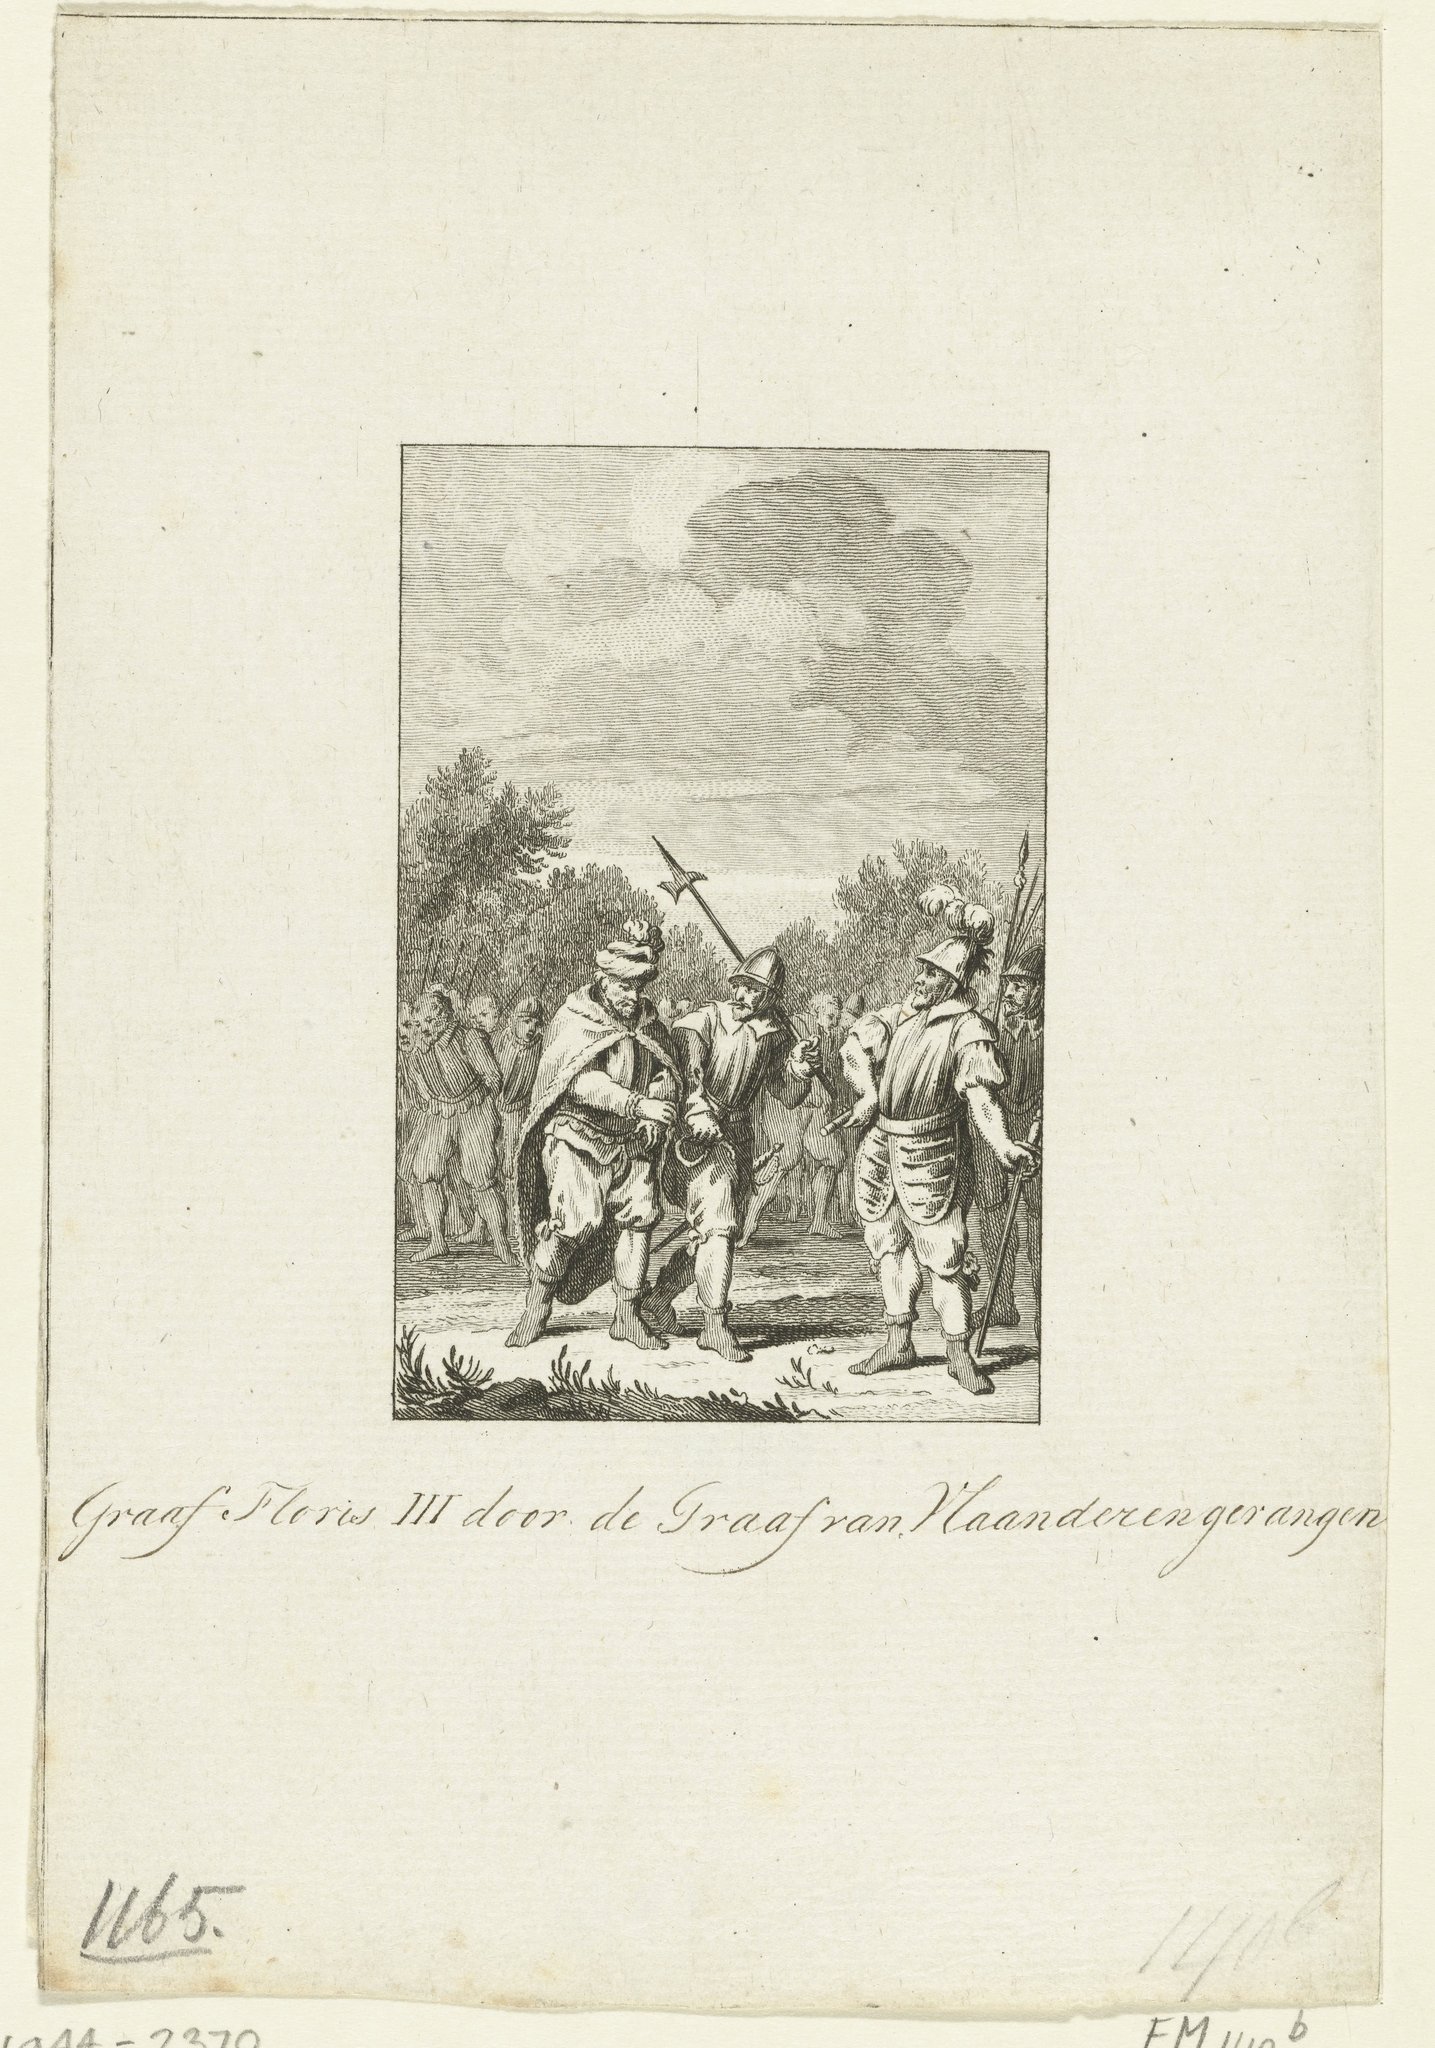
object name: print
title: Graaf Floris III door de graaf van Vlaanderen gevangen, 1165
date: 1780-1795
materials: paper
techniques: etching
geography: netherlands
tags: prisoner of war (after the battle)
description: Illustratie voor: J. Fokke, Geschiedenissen der Vereenigde Nederlanden voor de vaderlandsche jeugd, Johannes Allart, Amsterdam 1783-1795, 25 delen, dl. II, pl. IV. Staat vóór de letter.